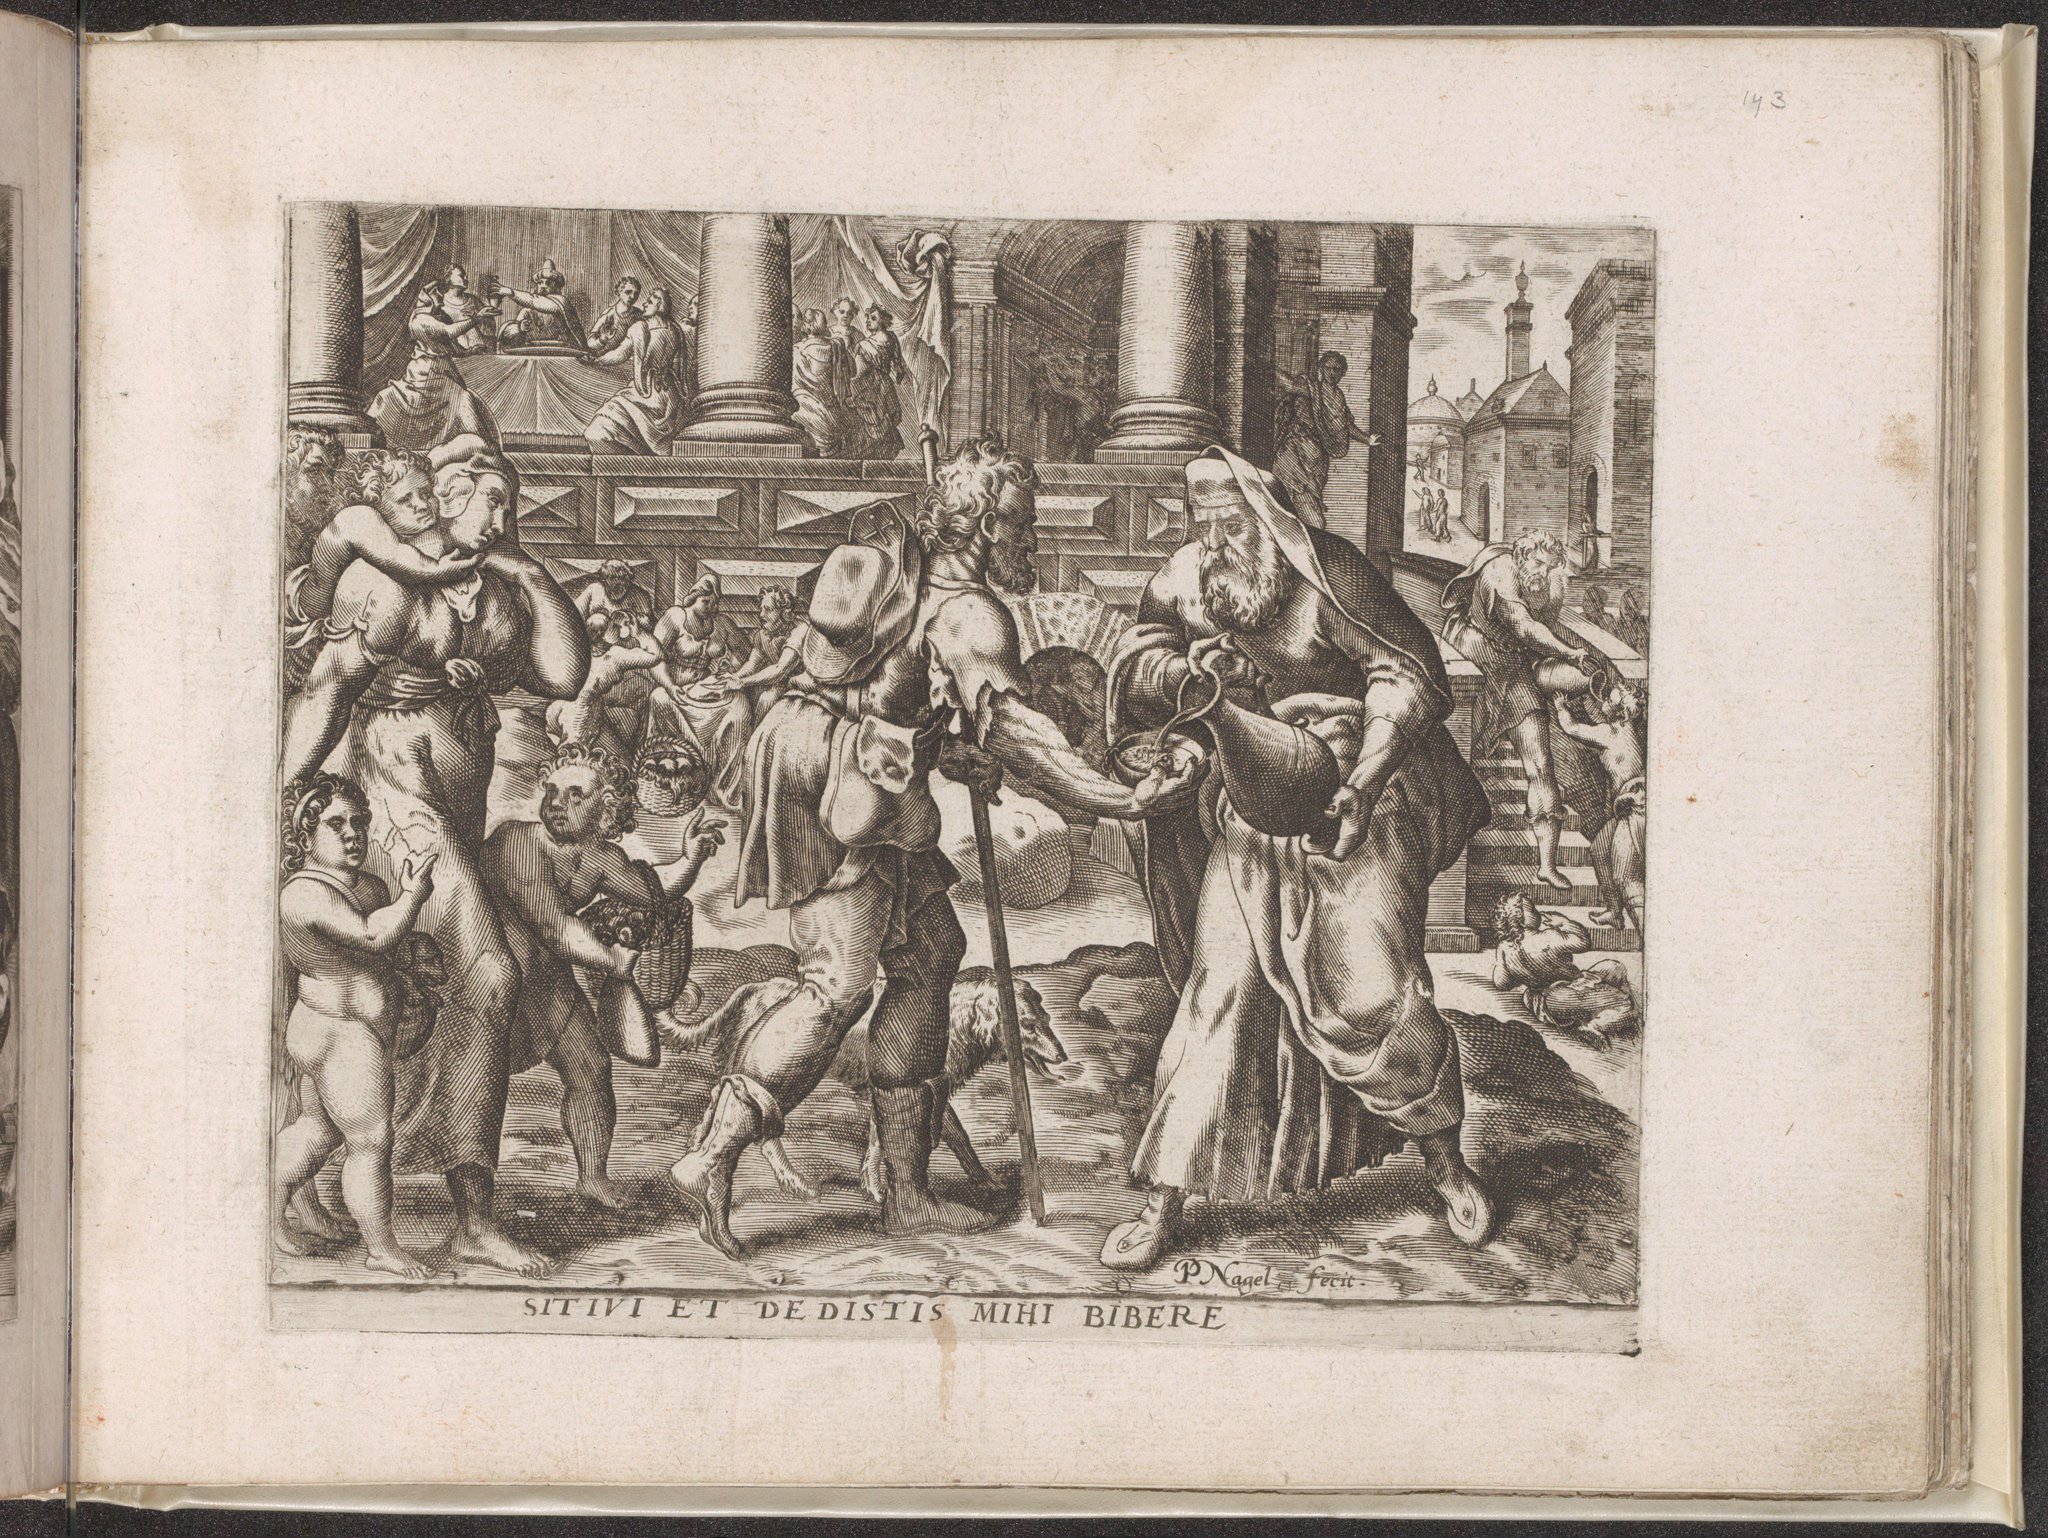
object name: album leaf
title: Dorstigen te drinken geven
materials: paper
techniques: engraving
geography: antwerp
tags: giving the thirsty to drink, 'sitiens potatur' ~ one of the (seven) acts of mercy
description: Een man giet water uit een kruik in de drinknap van een man. Links een vrouw met een kind op haar rug. Op de achtergrond een zuilengalerij, waar mensen te drinken krijgen. Onder de voorstelling een verklarende tekst in het Latijn. Deze prent maakt deel uit van een album.